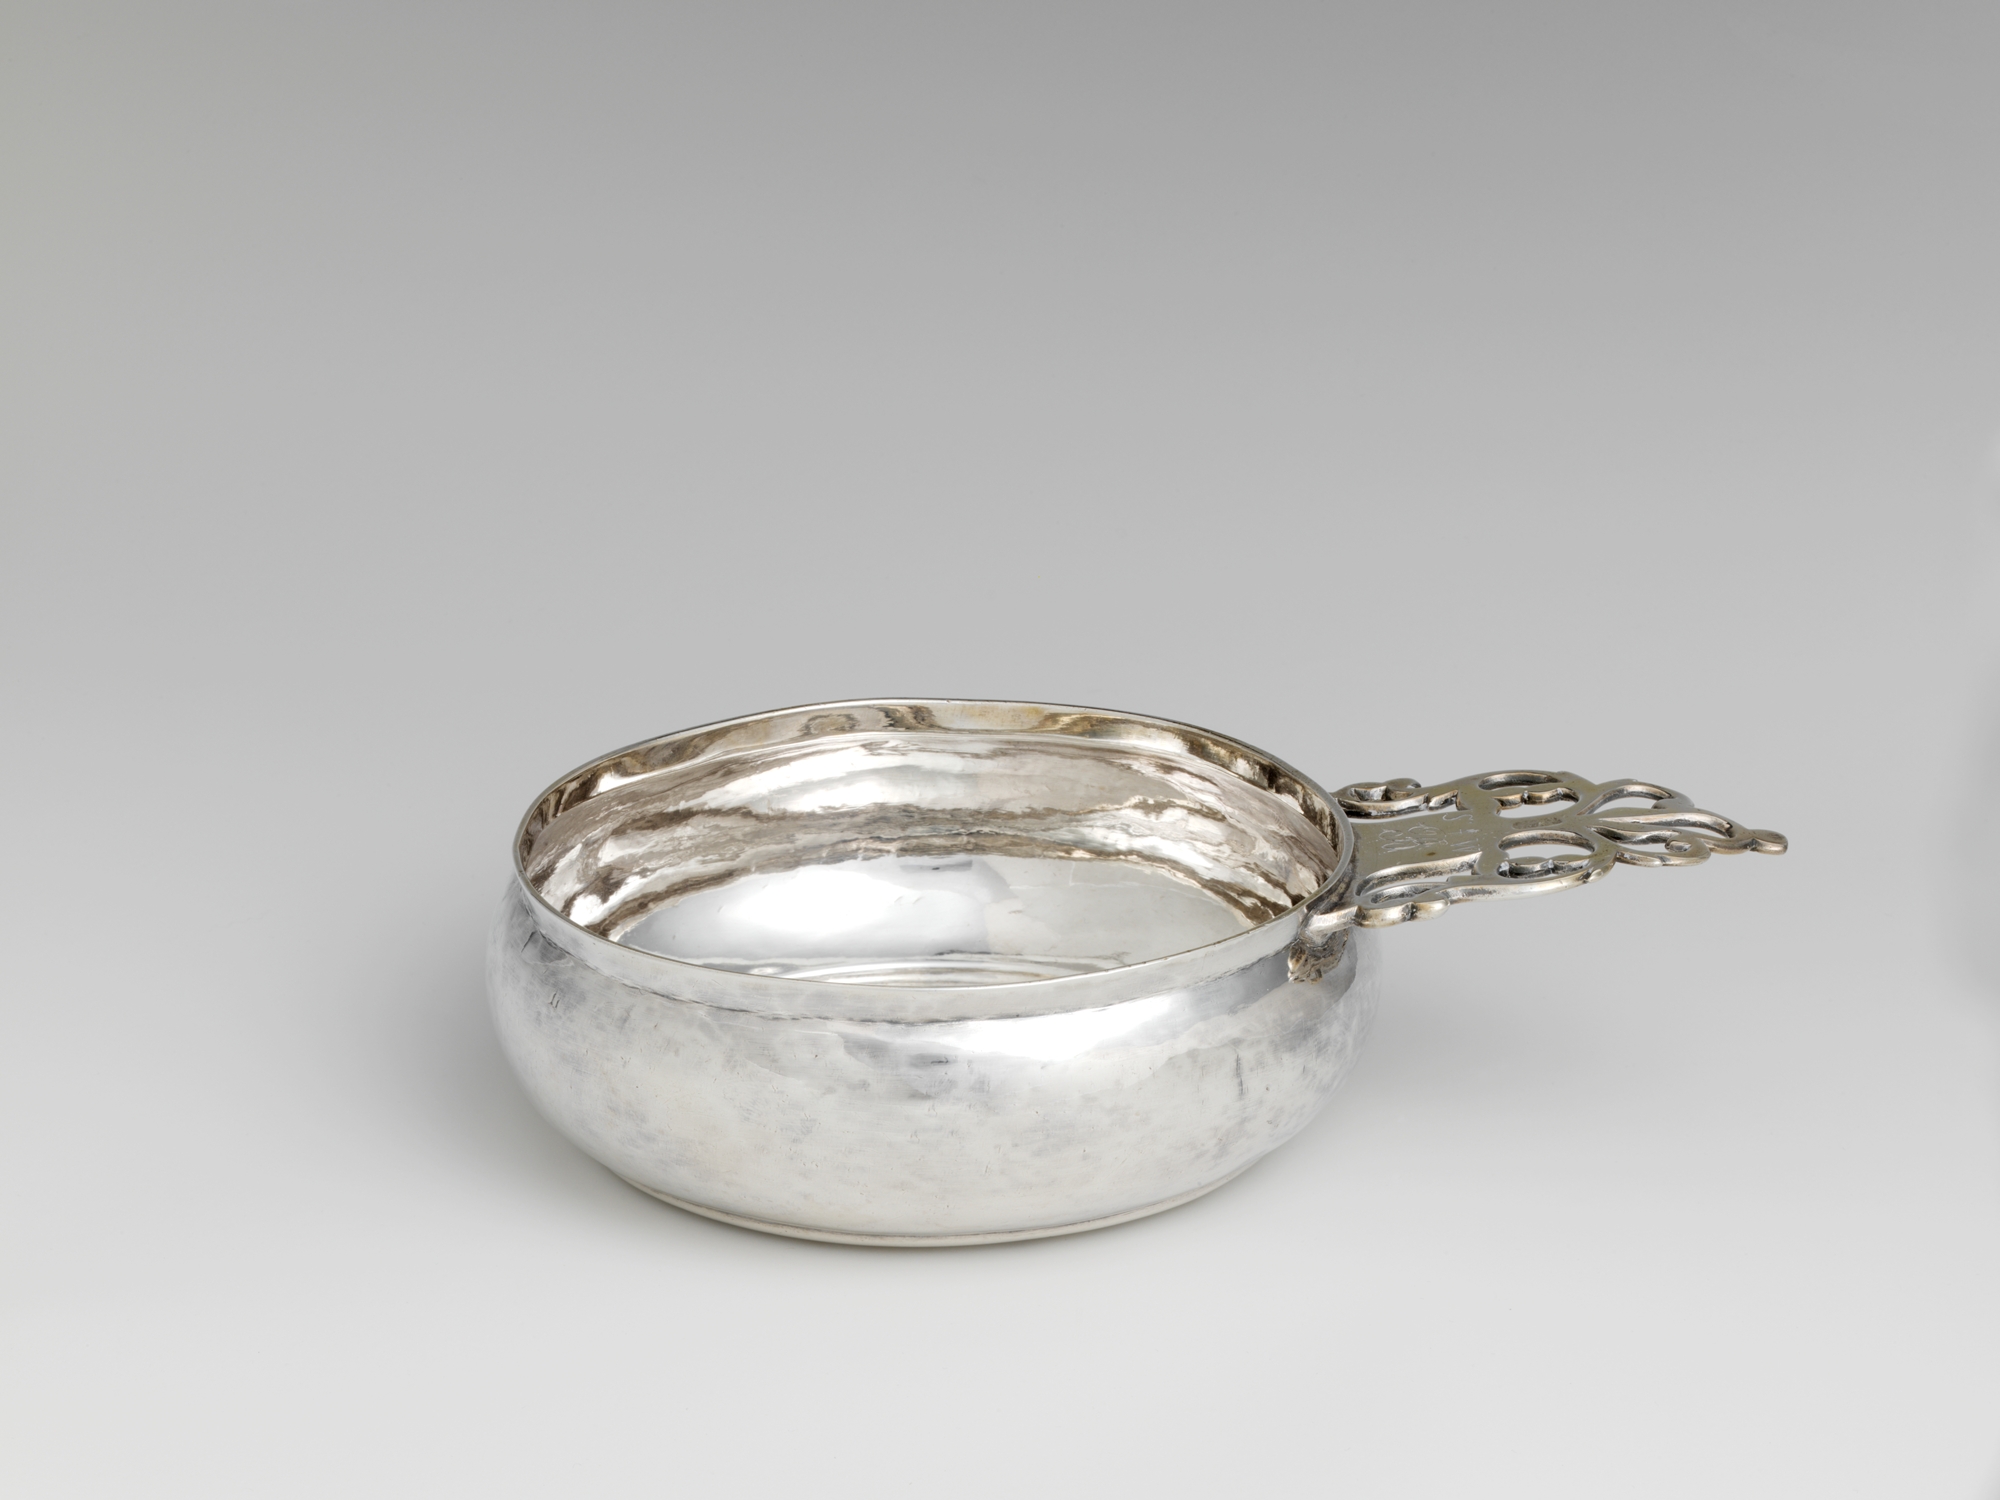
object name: porringer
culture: american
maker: john burt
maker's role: maker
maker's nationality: american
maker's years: 1692-1746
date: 1725-1745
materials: silver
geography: united states